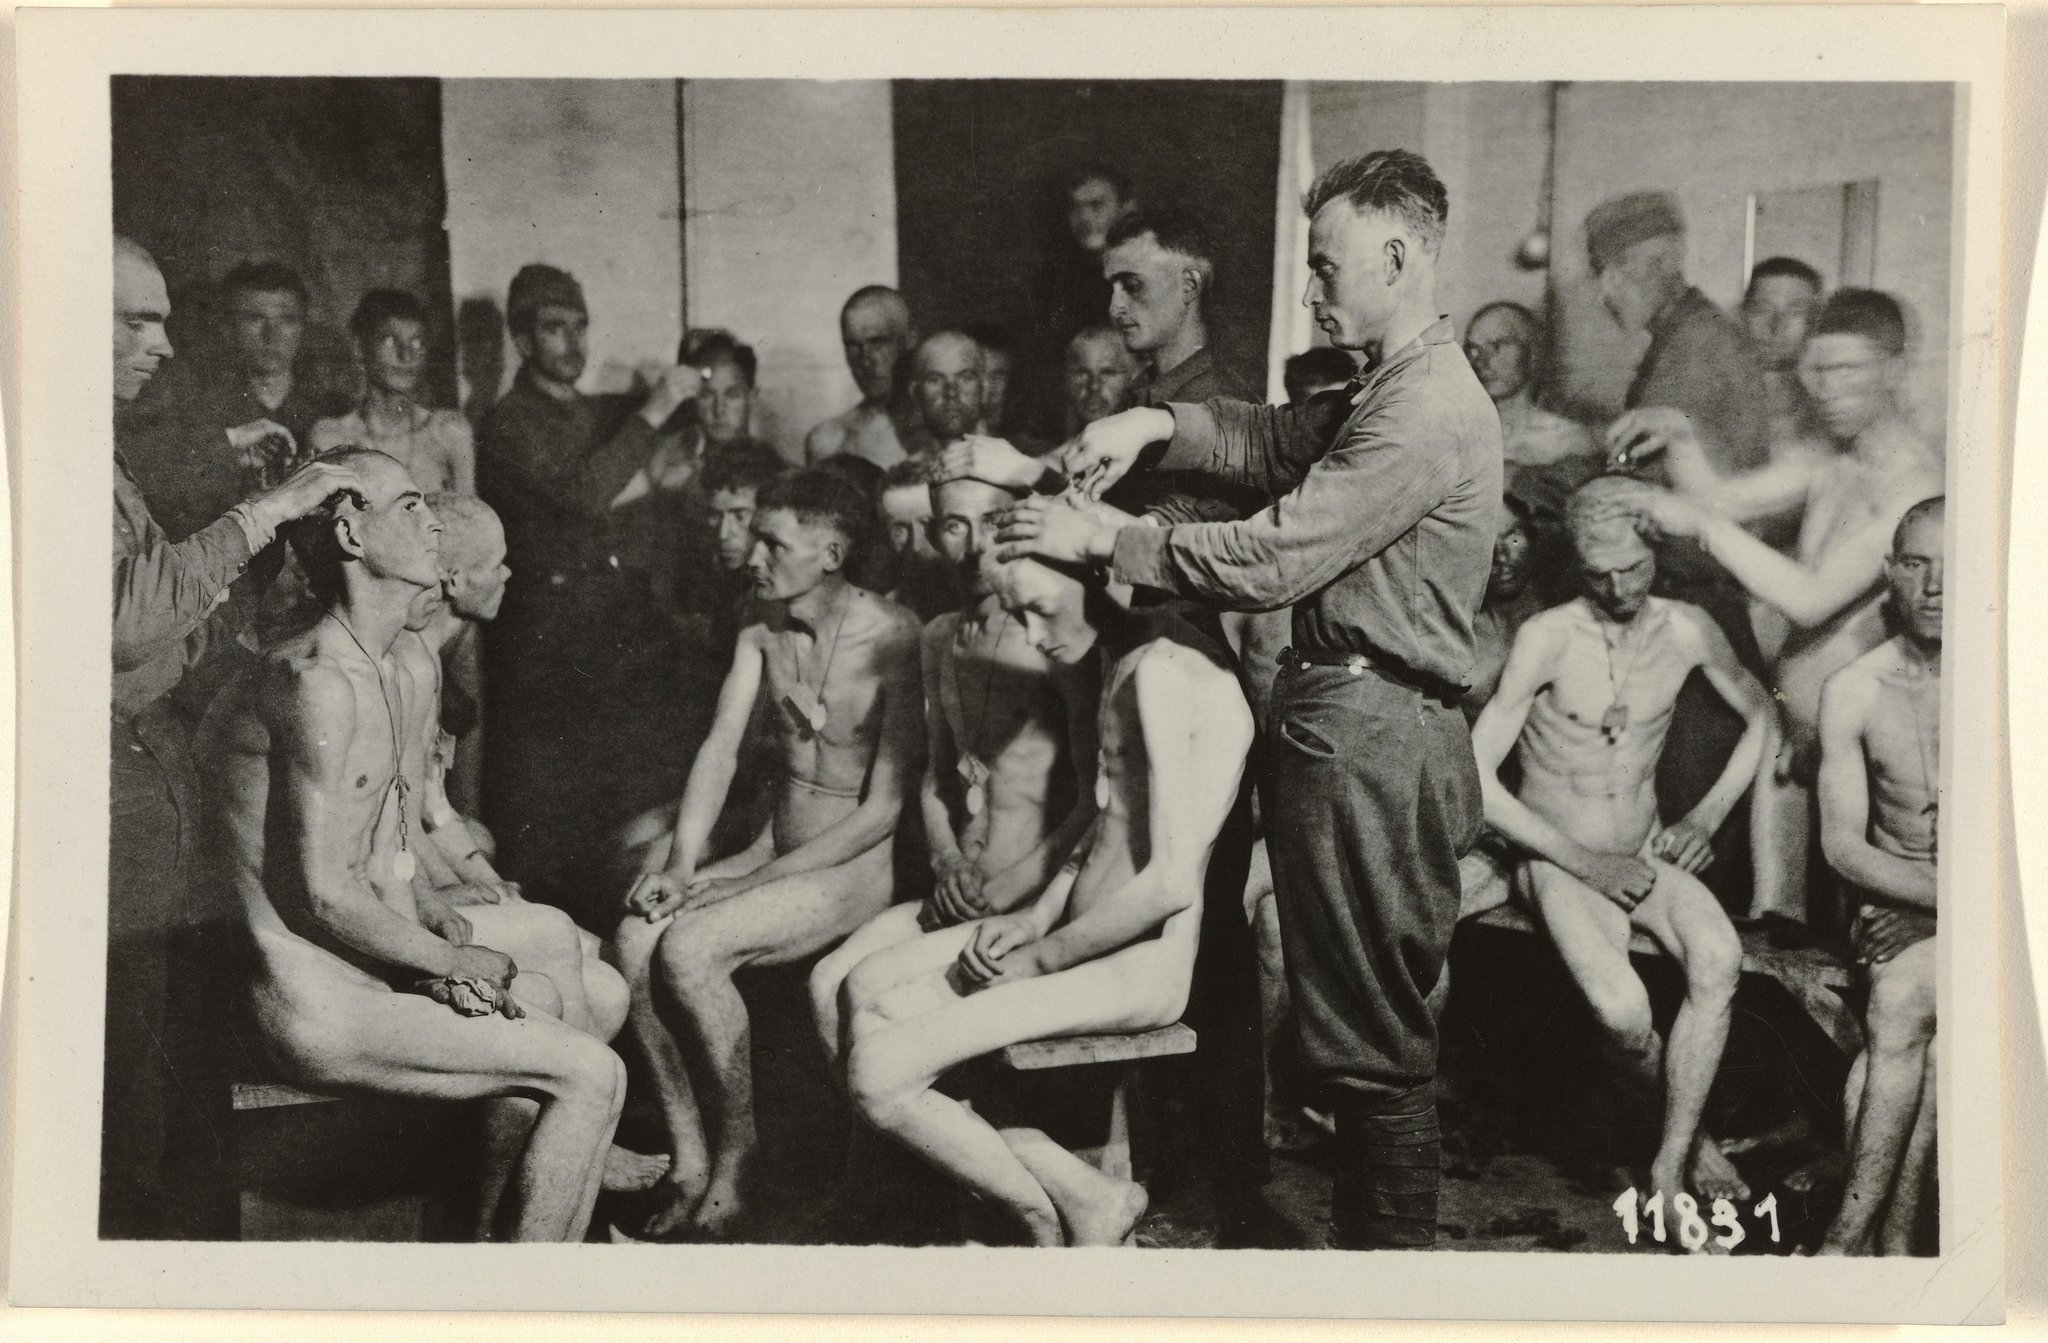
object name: photograph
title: Delicing in Camp Stalag IV B, Mühlberg, Germany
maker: dick w.b. van maarseveen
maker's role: fotograaf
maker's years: 1905-1990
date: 1943-1945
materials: photographic support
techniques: gelatin silver print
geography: muhlberg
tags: the hague, dick w.b. van maarseveen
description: The Dutchman Van Maarseveen was assigned a job as a photographer while he was a military prisoner of war in the Stalag IV B concentration camp in Mühlberg, Germany. For more than a year, the Germans employed him to record camp life; from the registration of new prisoners to theatrical performances and funerals. In these photographs we see emaciated, probably Russian, prisoners of war being stripped, deloused, and their heads shaved.